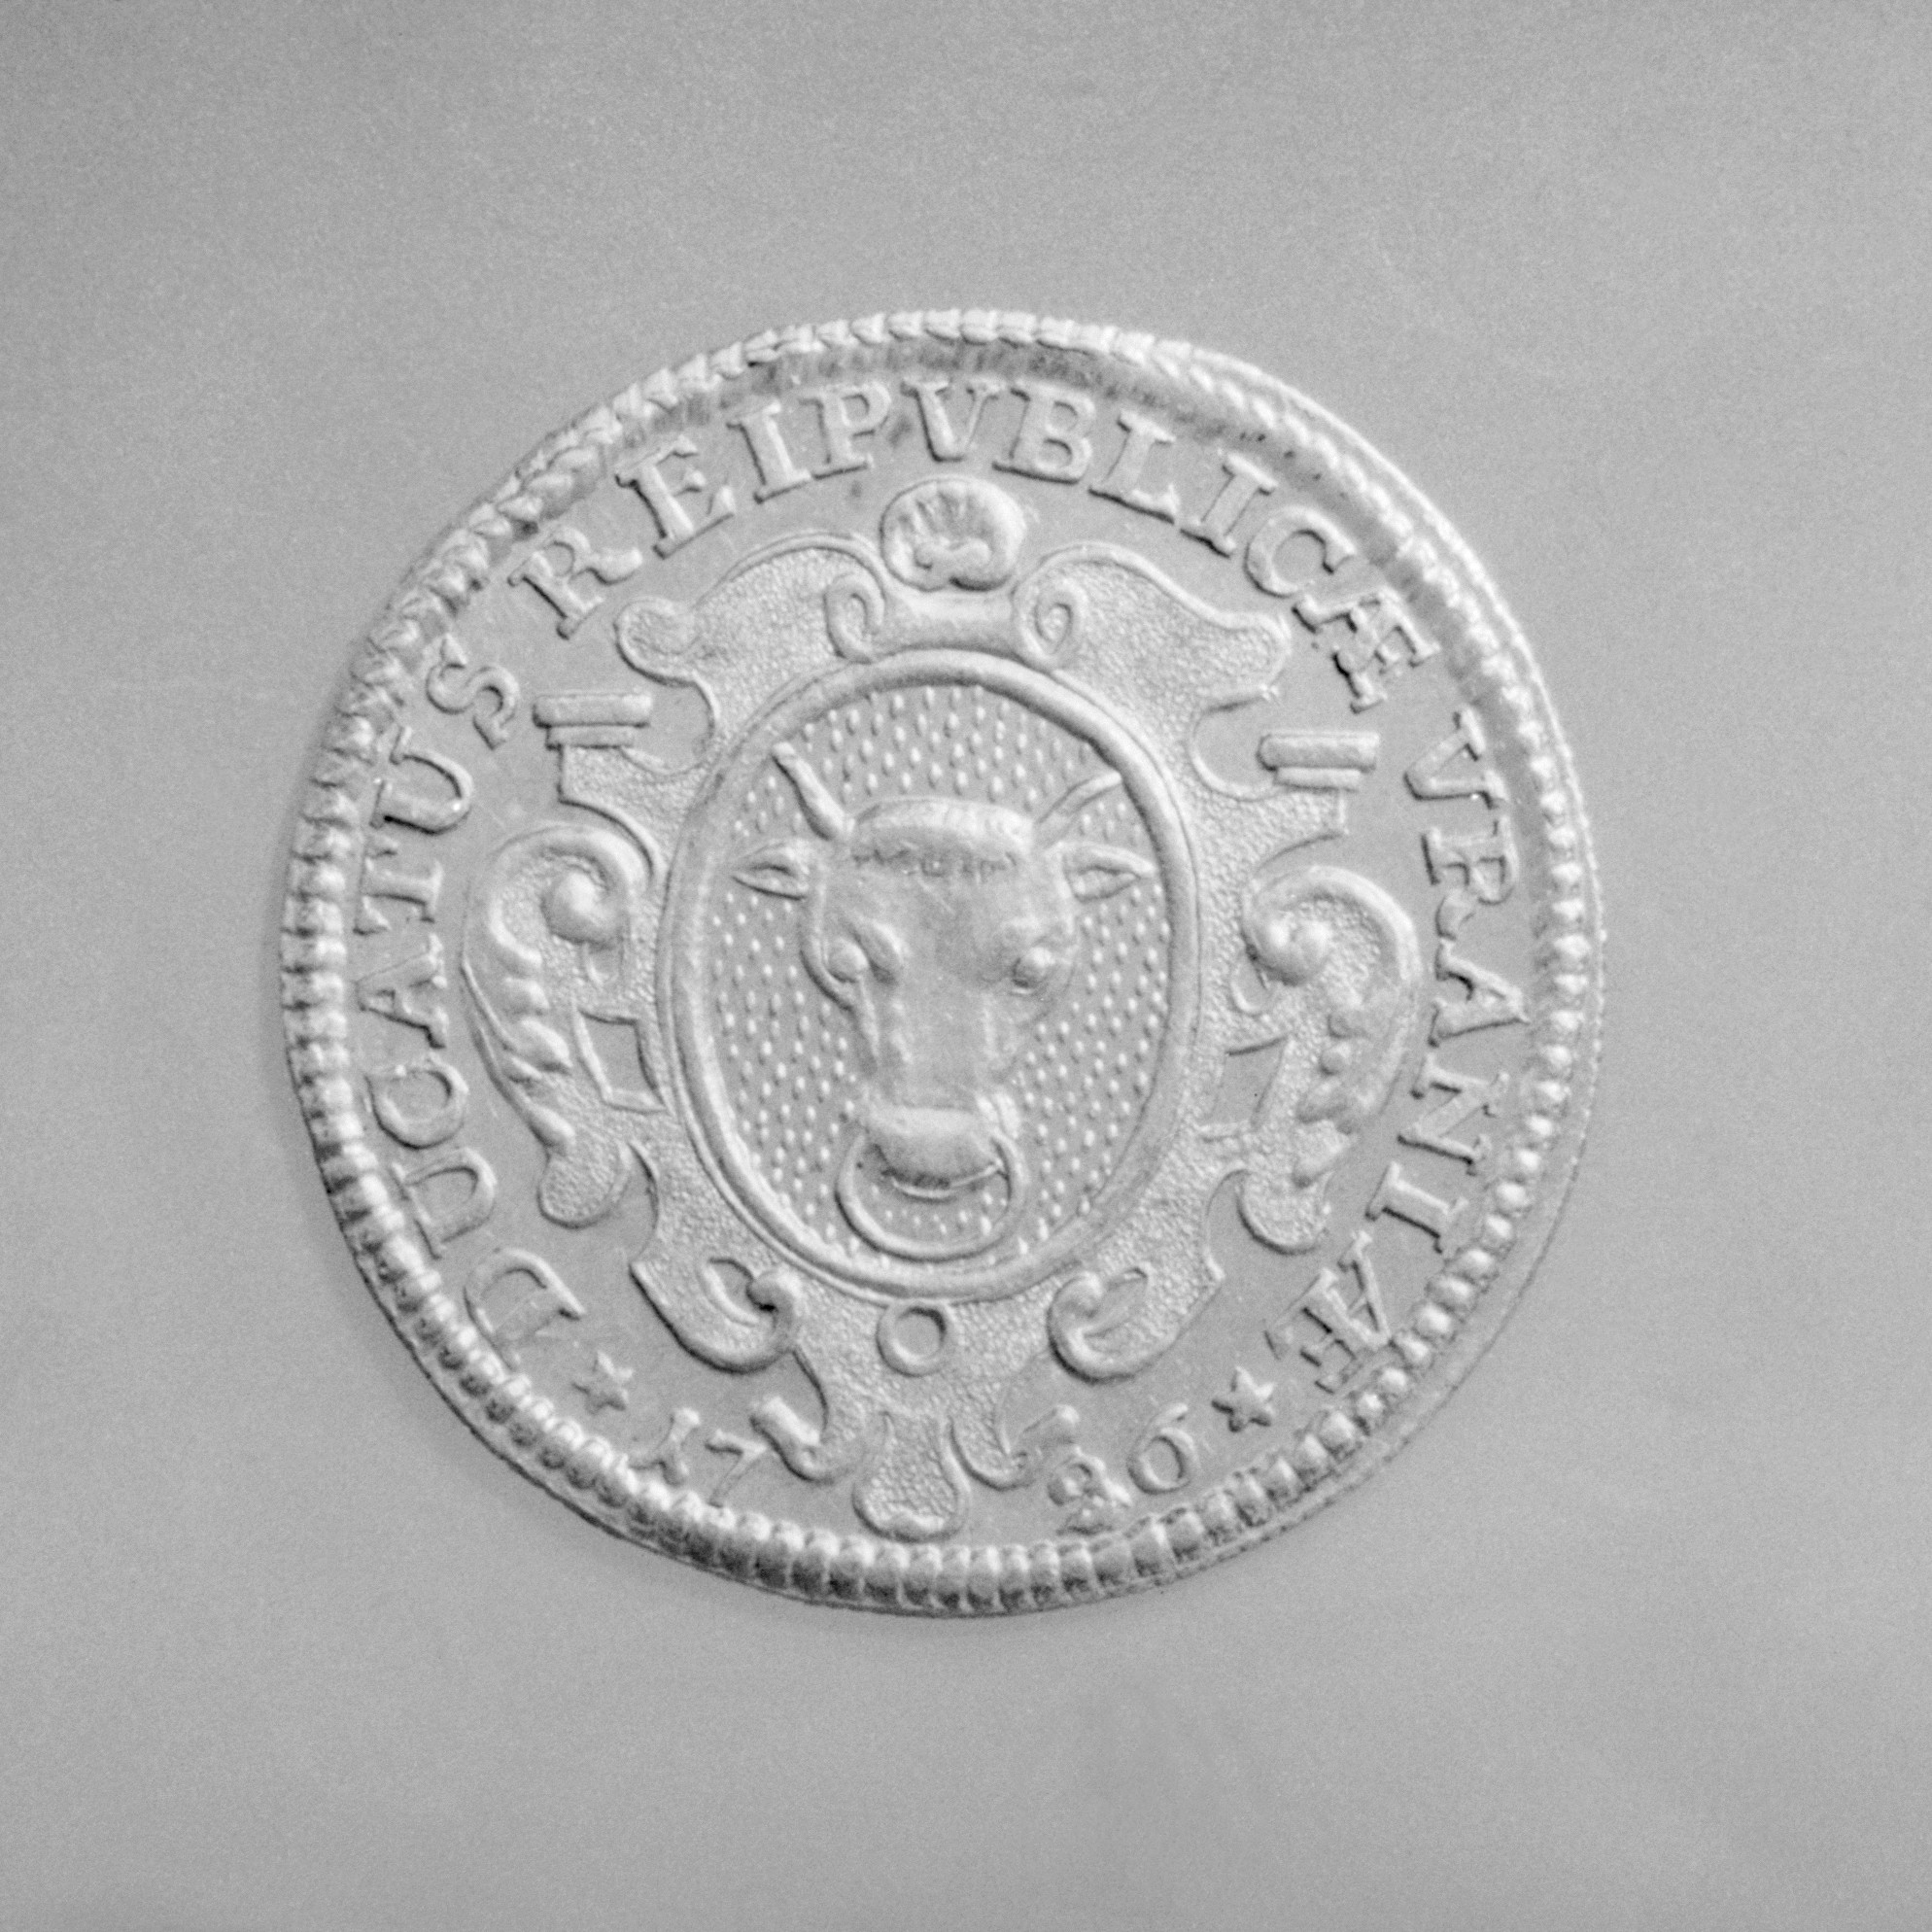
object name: ducat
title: Ducat of the Canton of Uri, Switzerland, 1736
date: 1736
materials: gold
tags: bulls,coins,insignia